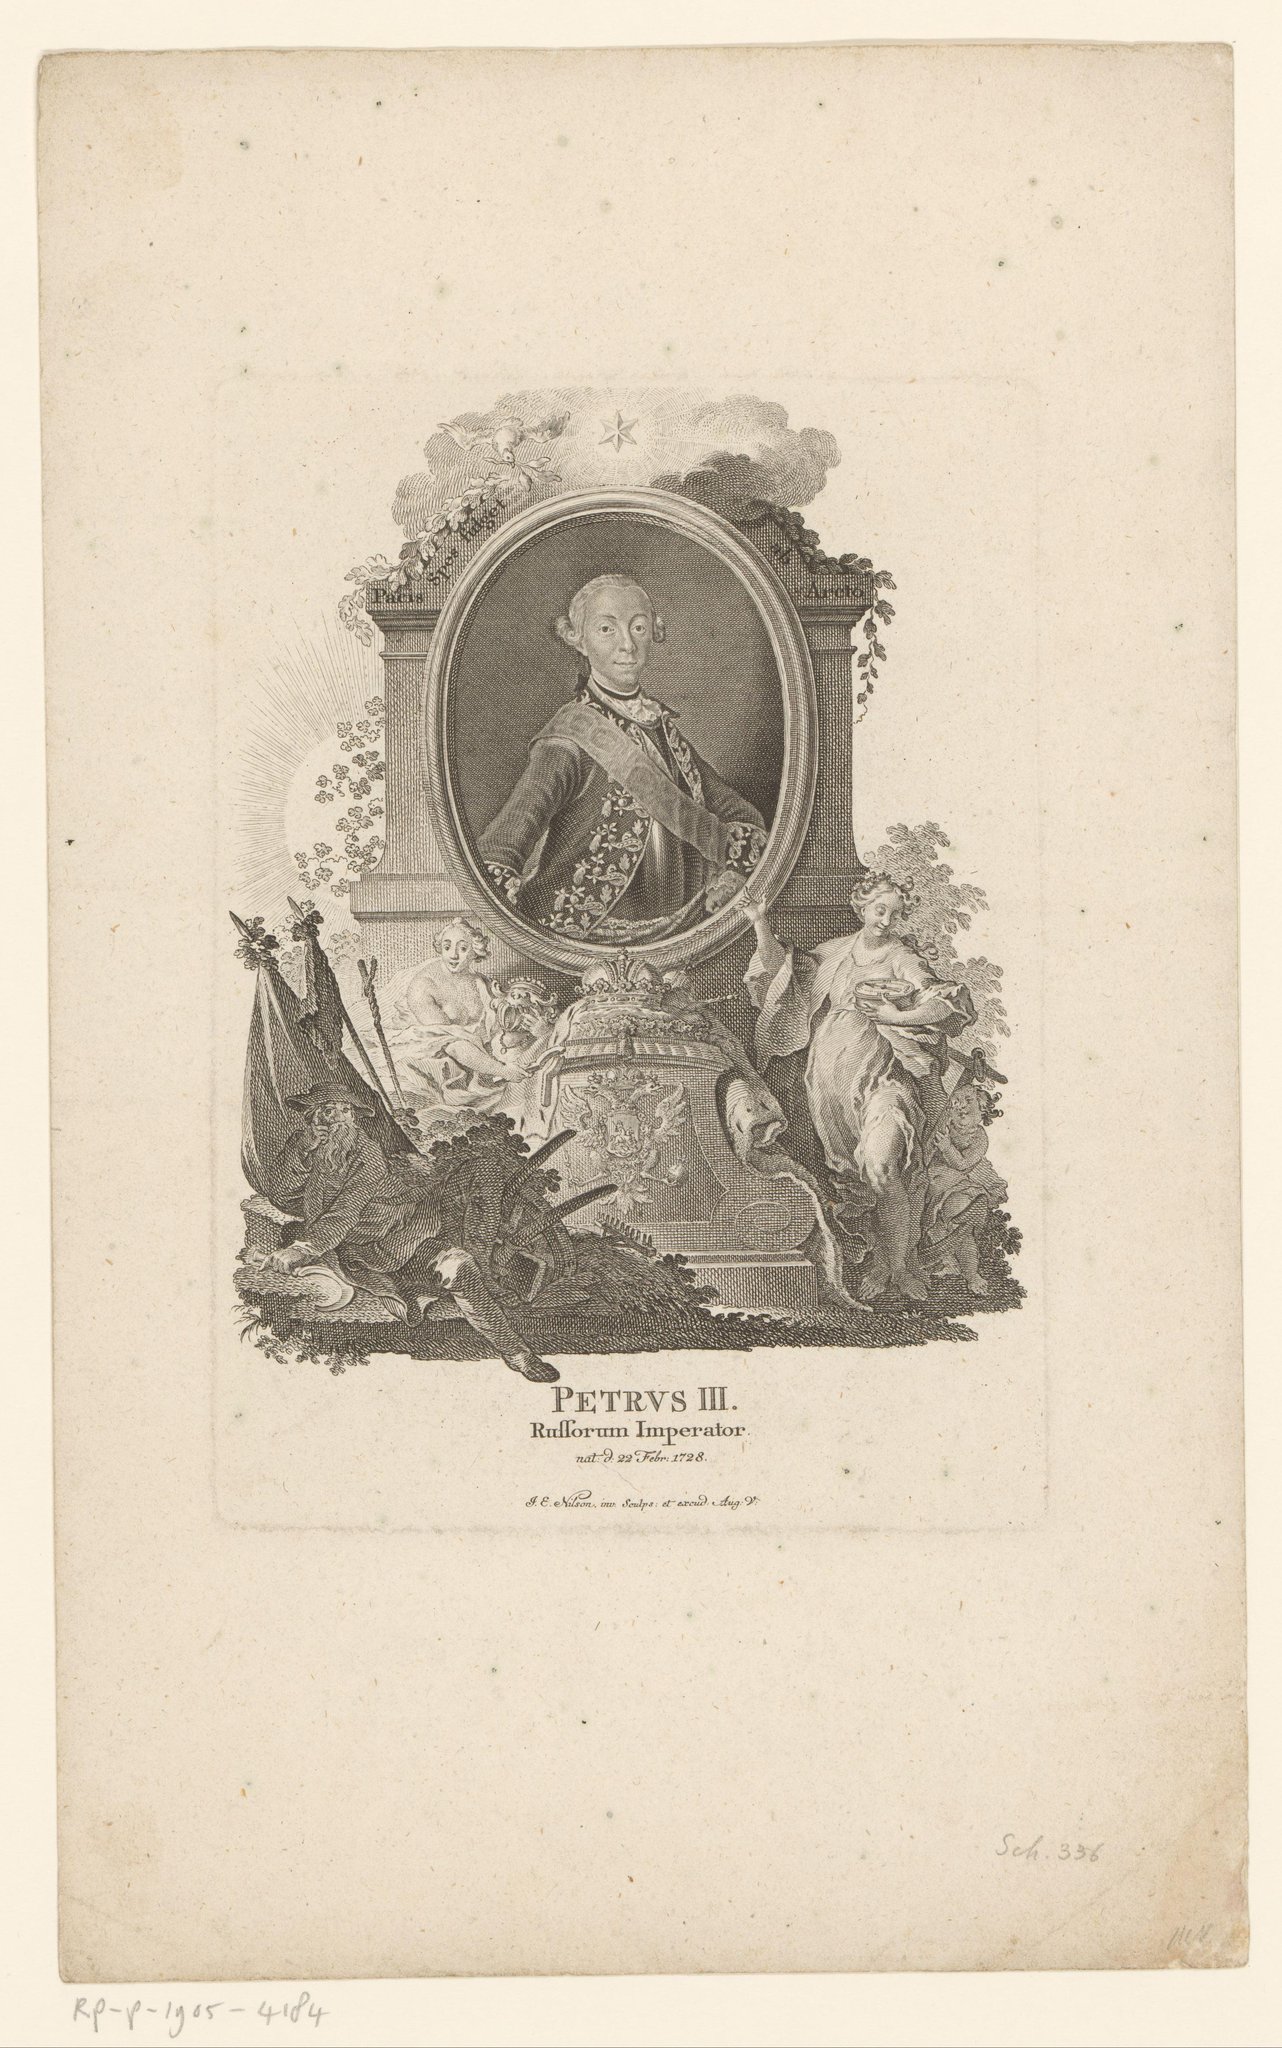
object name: print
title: Portret van Peter III, tsaar van Rusland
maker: johann esaias nilson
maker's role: draughtsman, print maker, publisher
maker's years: 1721-1788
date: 1762-1788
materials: paper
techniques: engraving, etching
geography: augsburg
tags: symbols of god the father, historical persons, parts of ship's exterior: anchor, agriculture, compass, baton of general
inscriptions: collector's mark: Lugt 2228